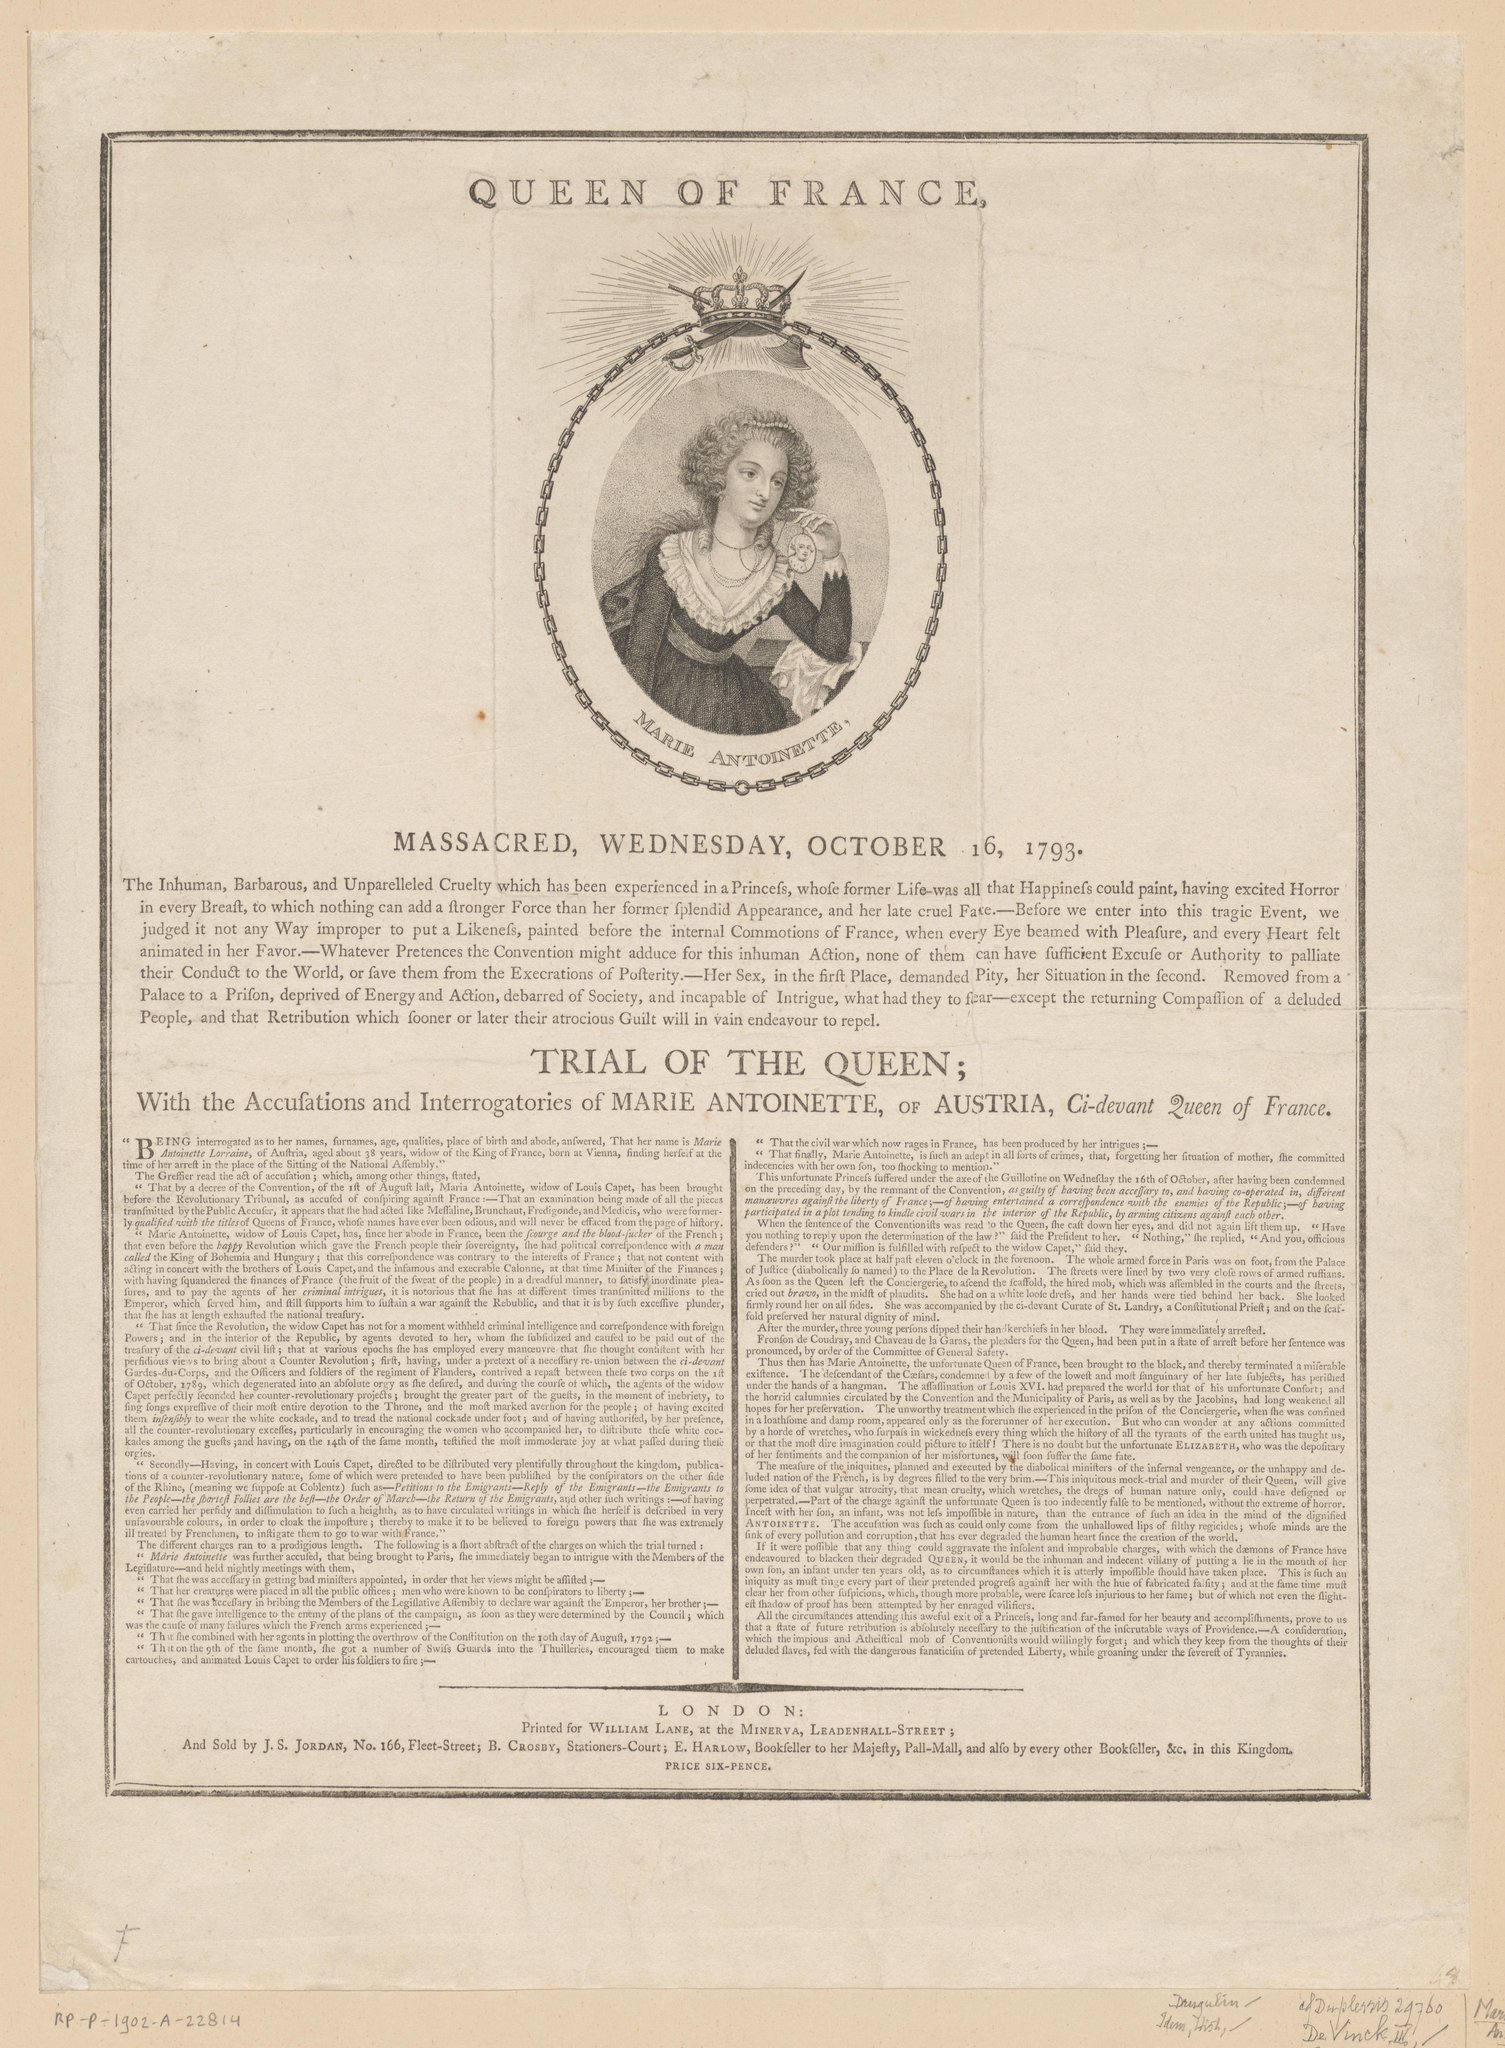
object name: print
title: Portret van Marie Antoinette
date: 1793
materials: paper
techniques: engraving, etching, letterpress printing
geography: london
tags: lodewijk xvi (koning van frankrijk), vienna, paris, marie antoinette, historical persons - bb - woman, queen, death penalty, execution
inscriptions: collector's mark: Lugt 2228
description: Marie Antoinette zit aan een tafel met een miniatuurportret van Lodewijk XVI in de linkerhand. Het ovale portret is omgeven door een ketting, met boven een kroon waar een sabel en een bijl doorheen gestoken is. Met onder het portret tekst in het Engels waarin haar executie wordt veroordeeld. Daaronder het verhoor van Marie Antoinette uitgeschreven in het Engels.